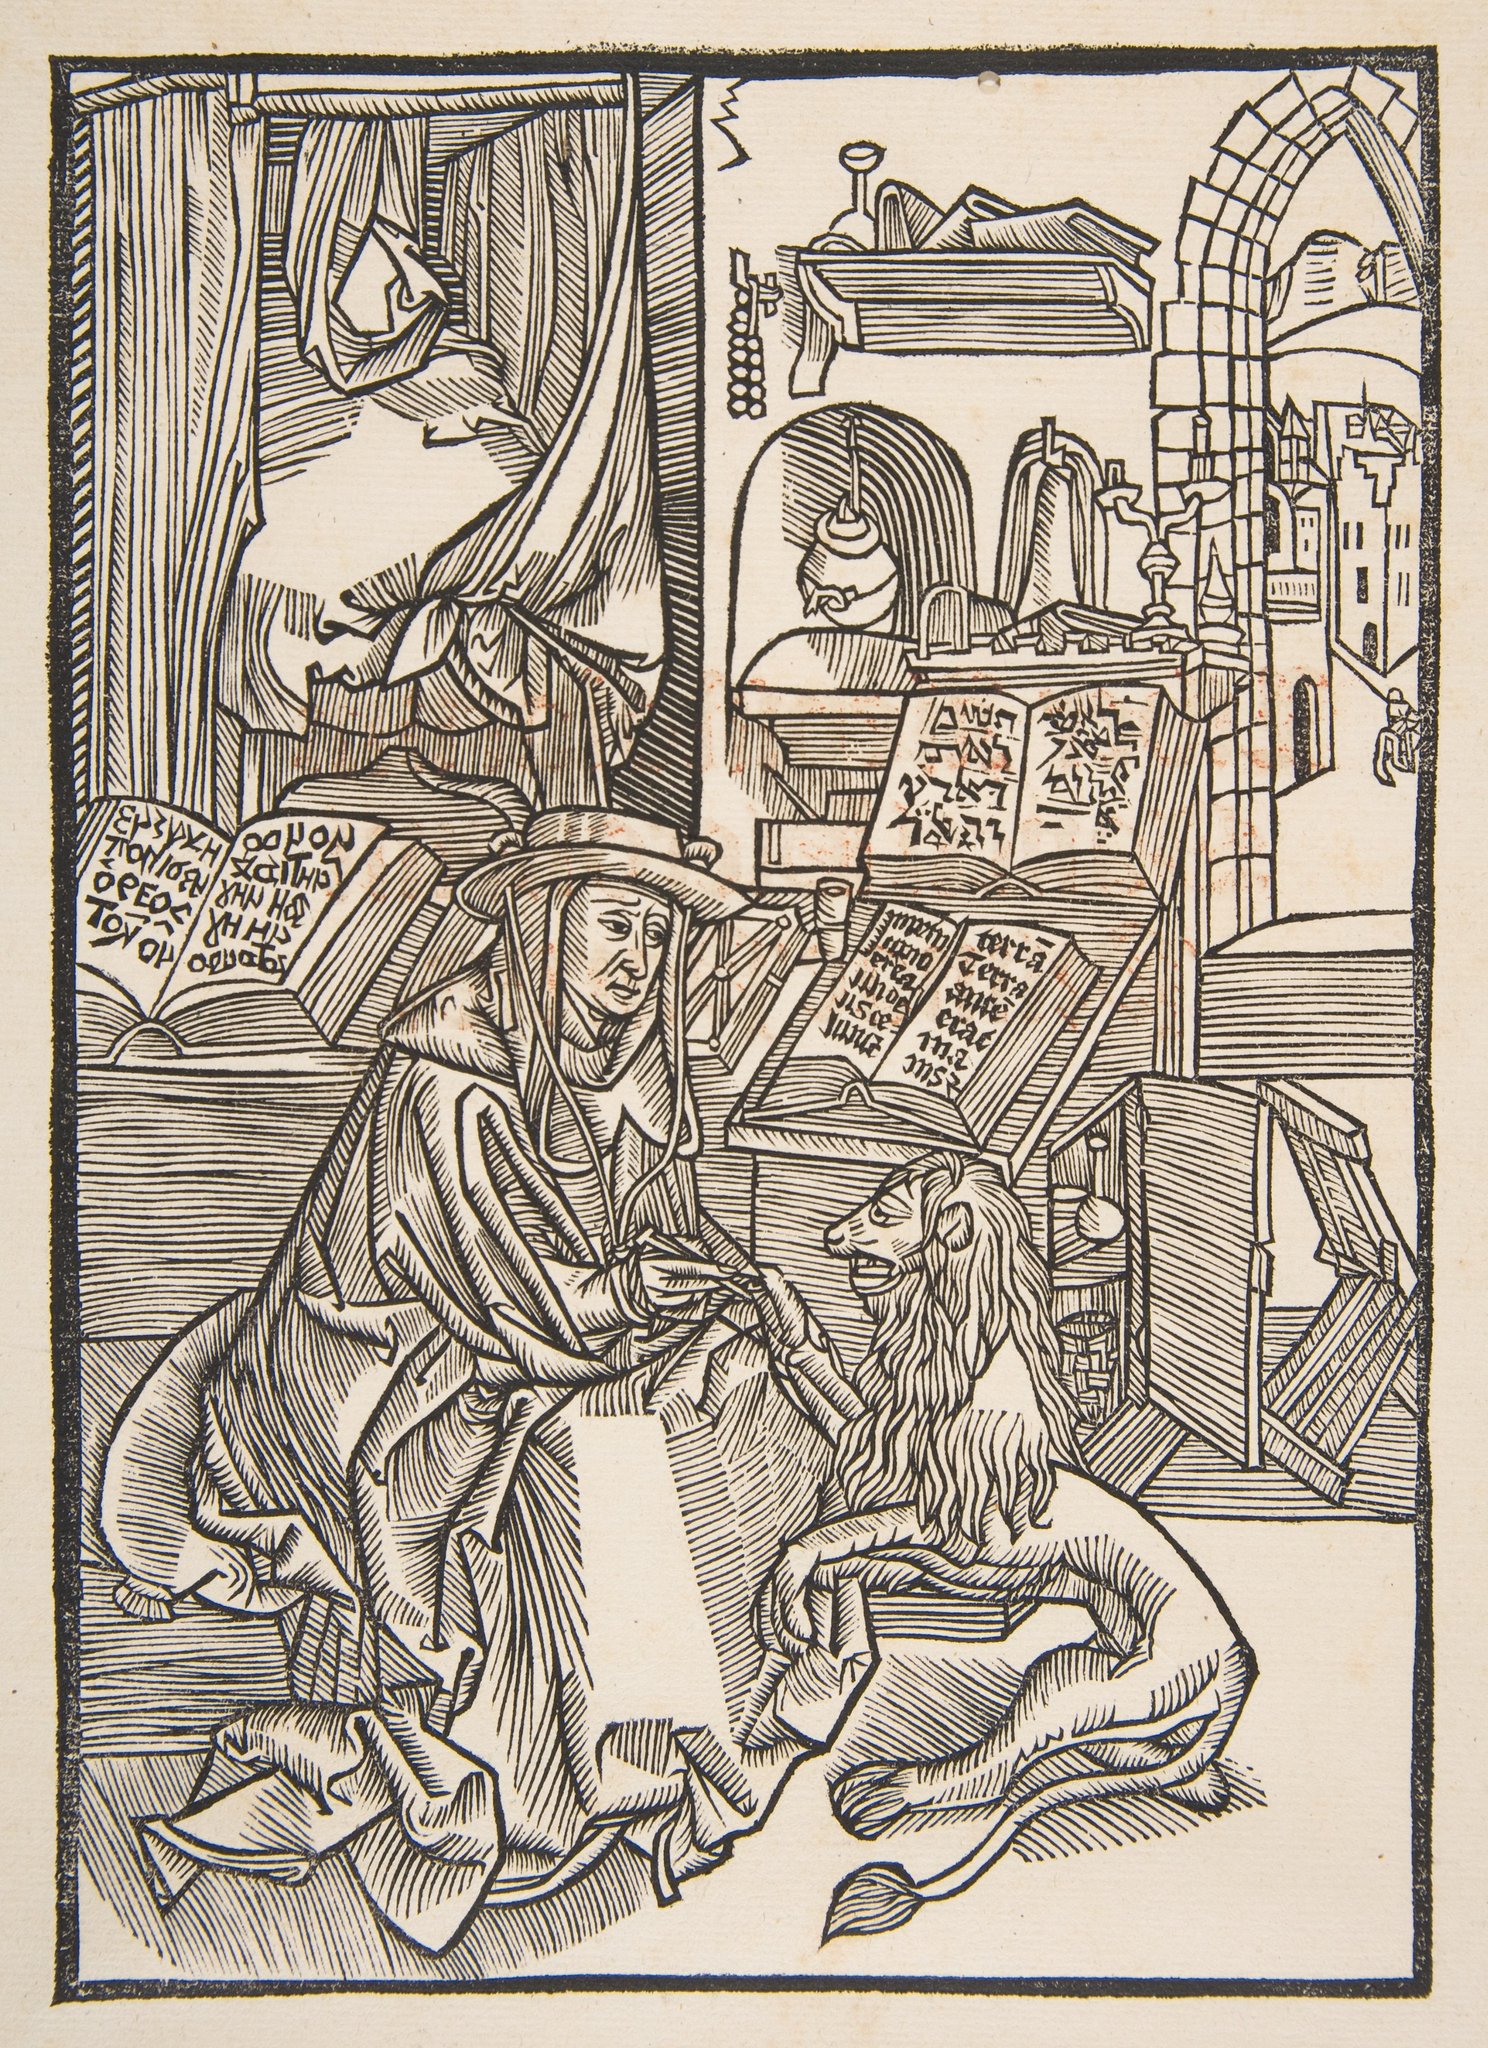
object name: print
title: Saint Jerome Extracting a Thorn from the Lion's Foot, Lyons 1508 (copy)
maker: albrecht dürer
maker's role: artist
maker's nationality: german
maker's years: 1471-1528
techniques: woodcut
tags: lions,saint jerome